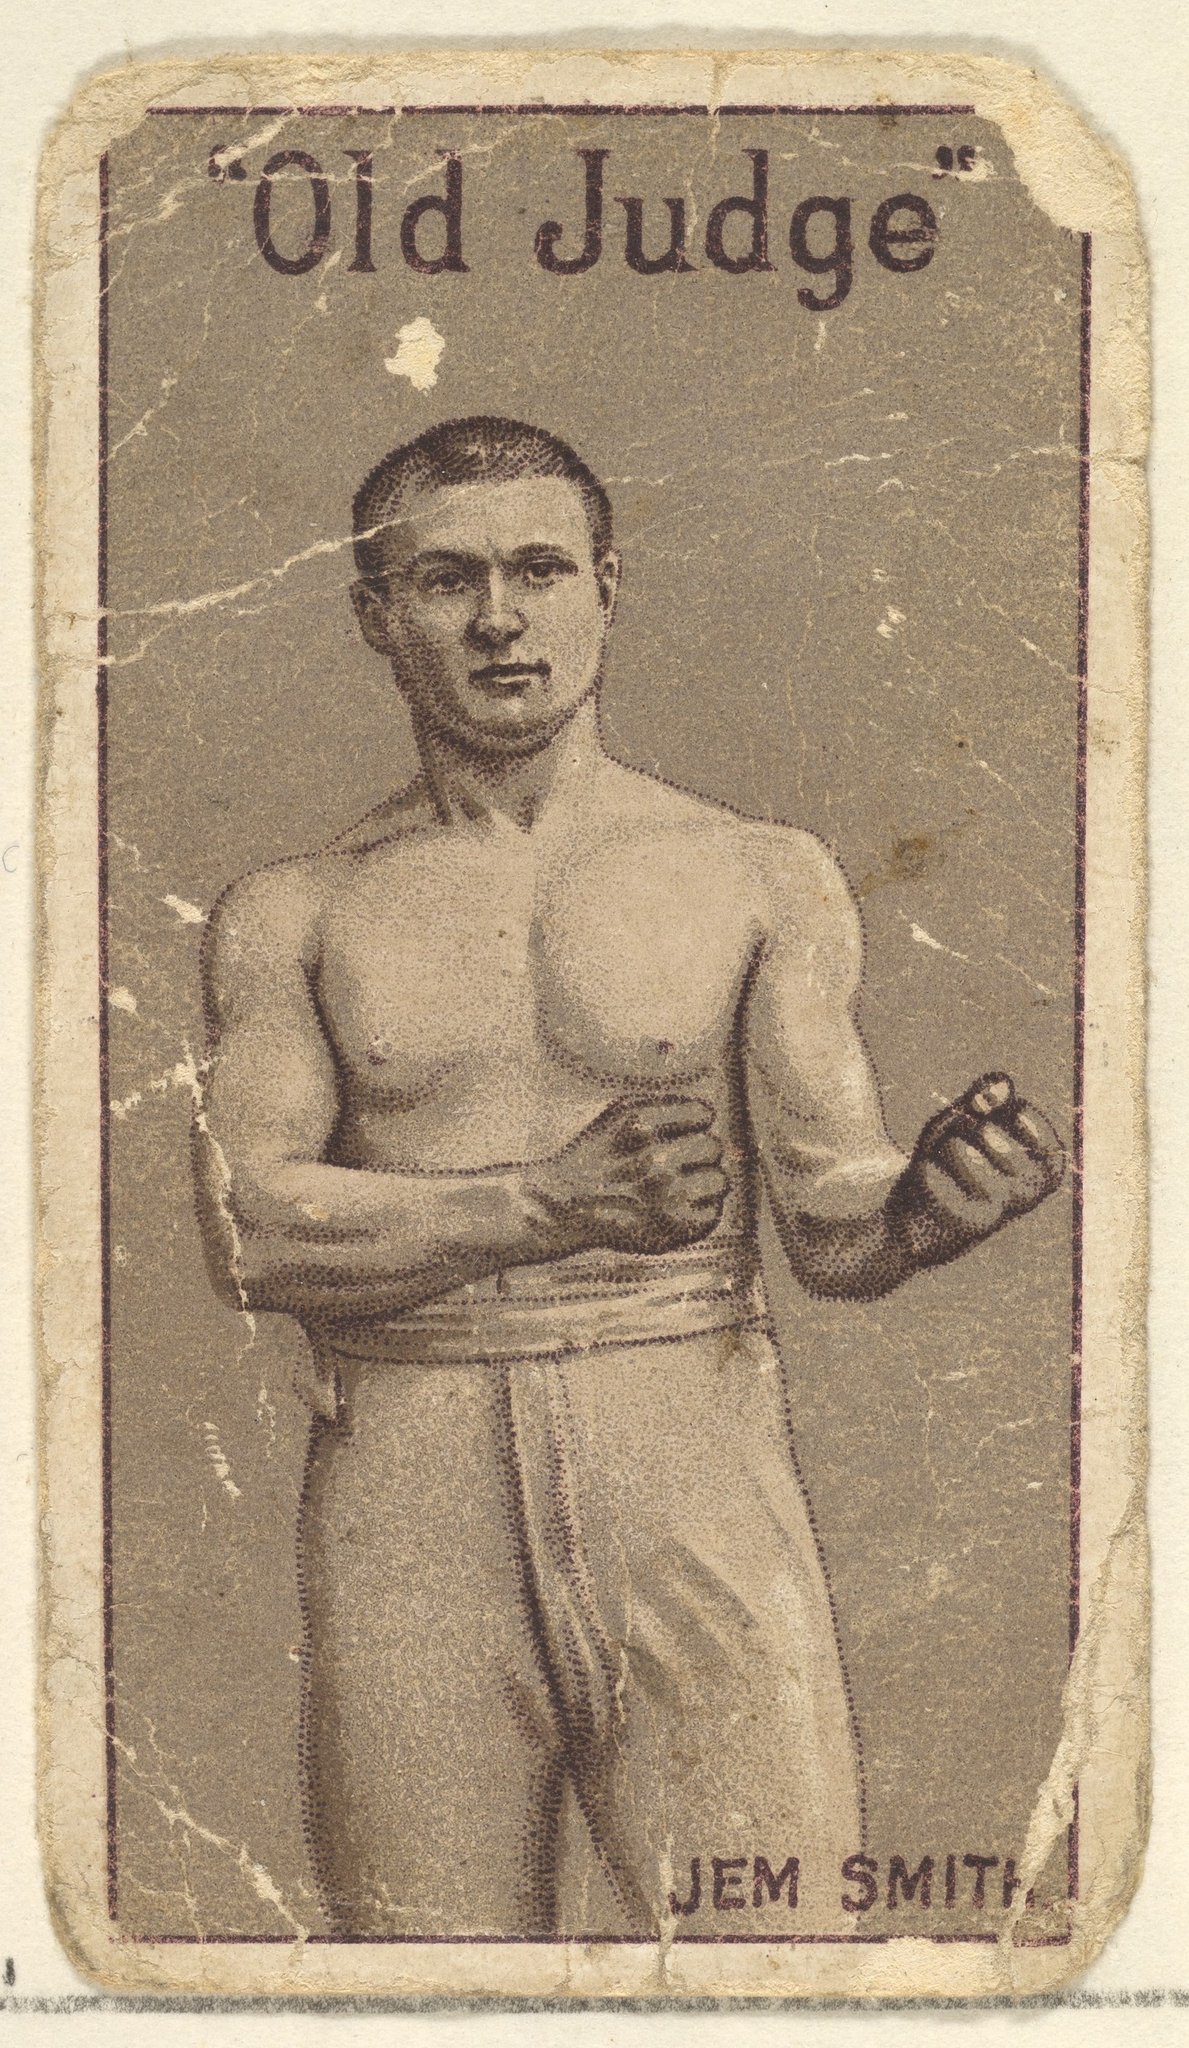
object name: print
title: Jem Smith (boxer) from the Old Judge series (N167) for Old Judge Cigarettes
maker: goodwin & company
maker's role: publisher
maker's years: 1850-1950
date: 1886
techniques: lithography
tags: men,boxing,athletes